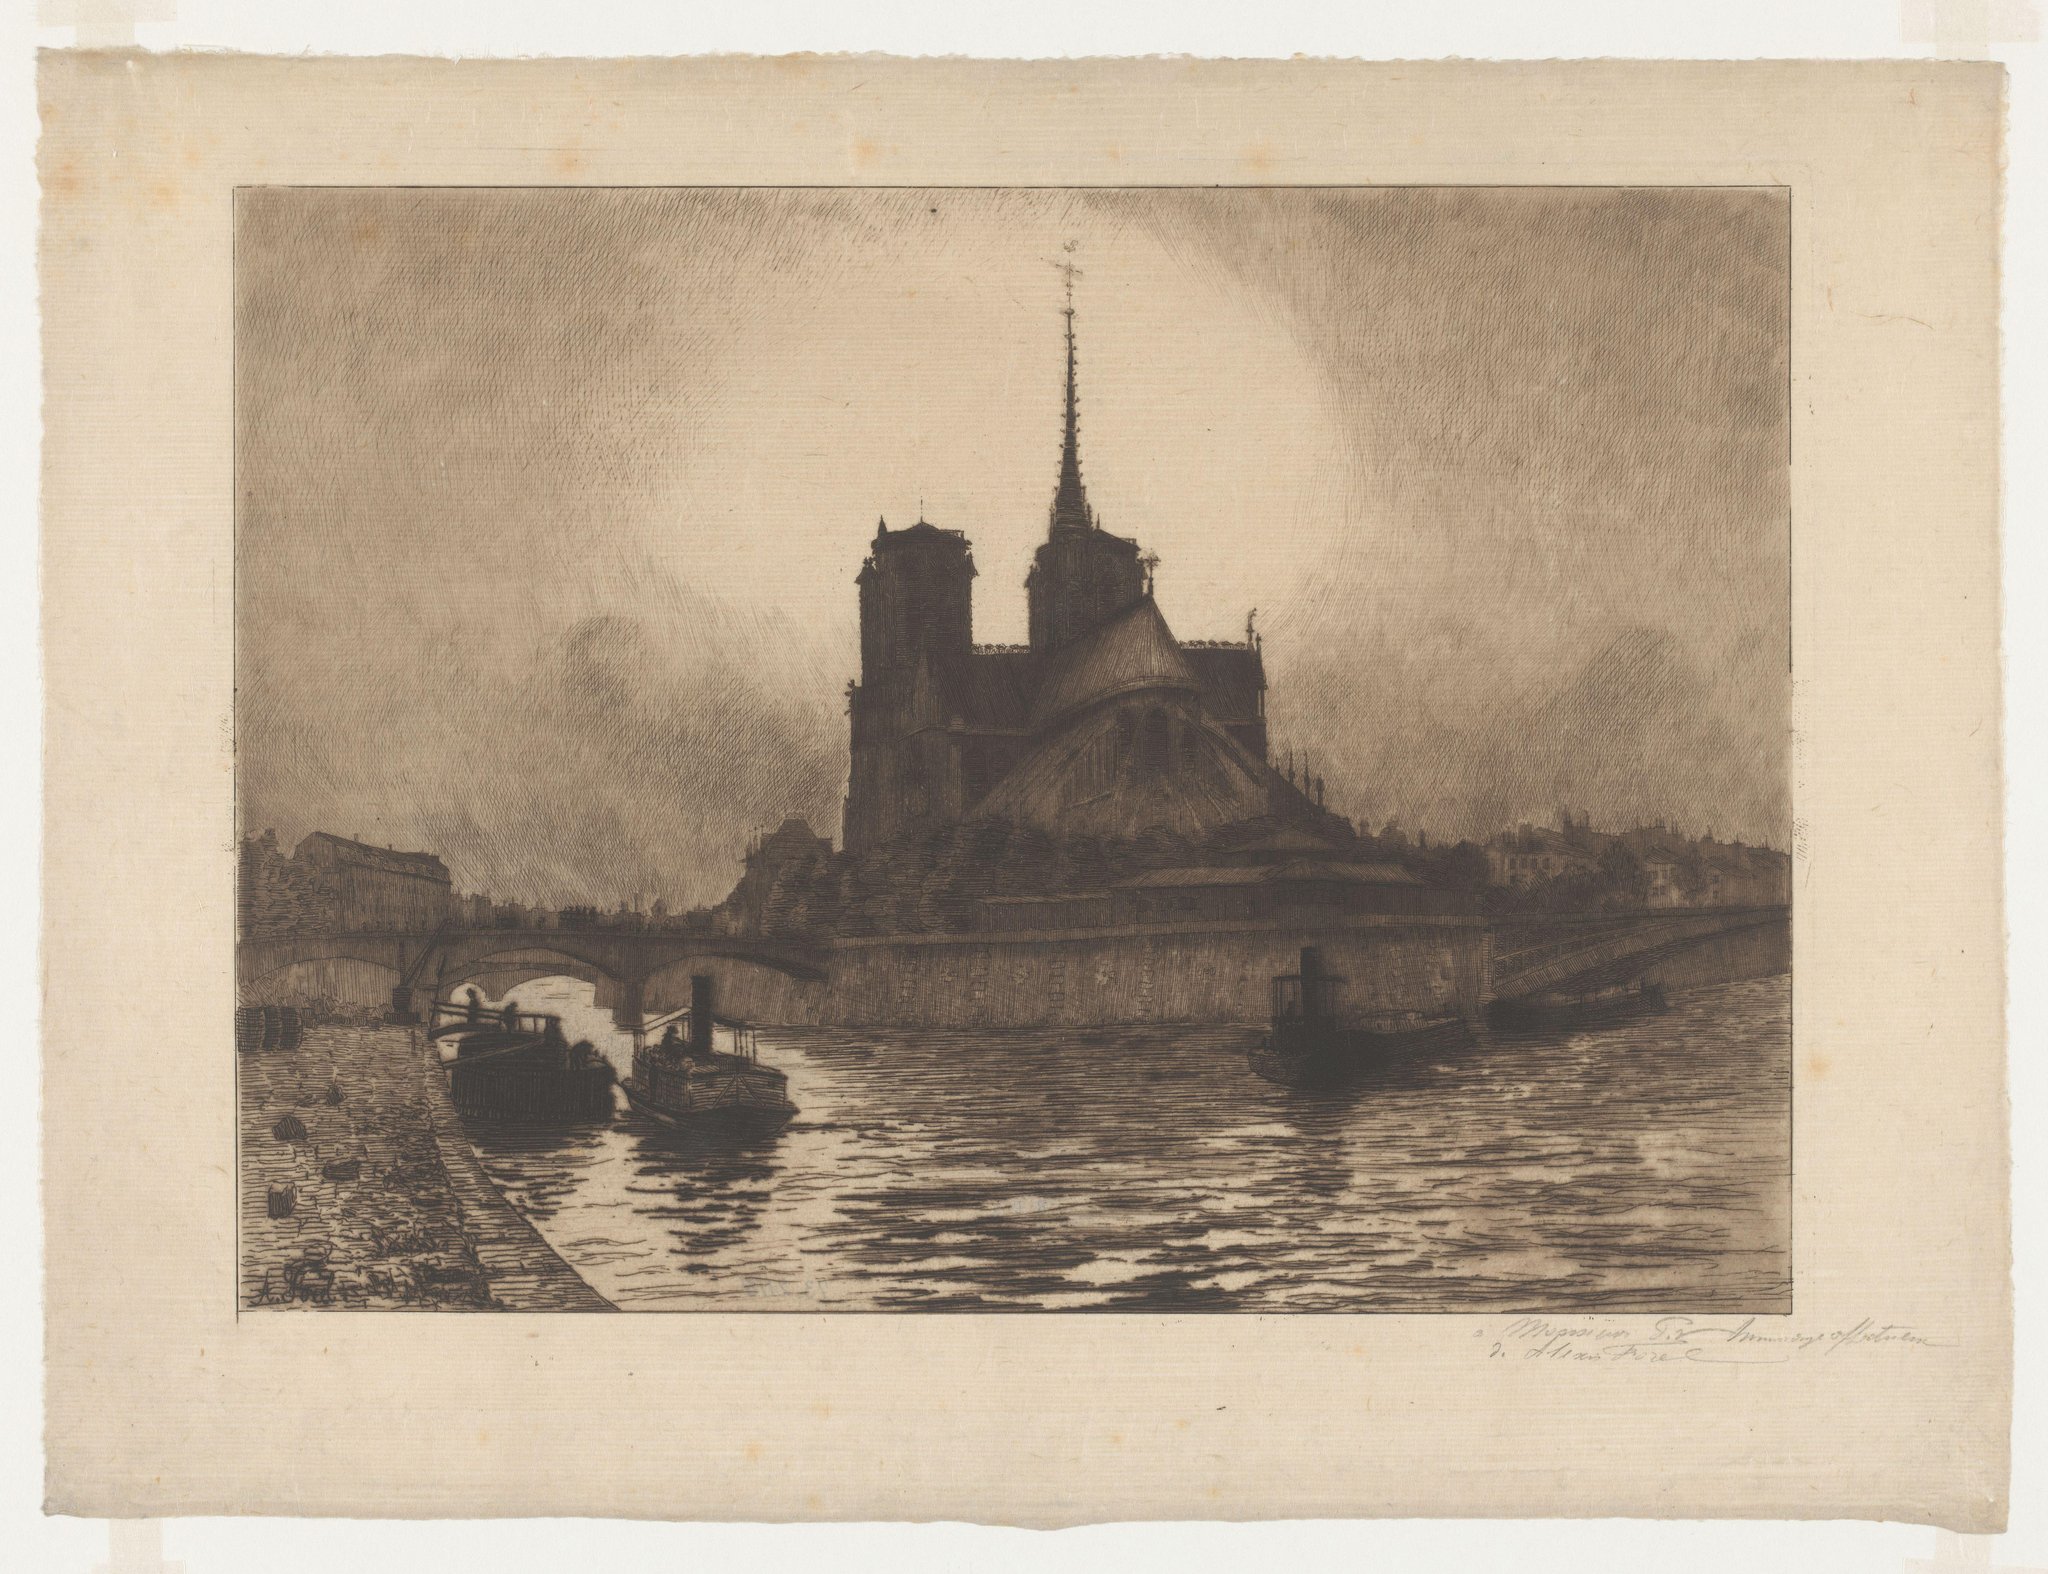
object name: print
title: Gezicht op de achterkant van de Notre-Dame te Parijs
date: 1862-1913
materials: paper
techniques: engraving, etching, intaglio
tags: city-view in general; 'veduta', church (exterior)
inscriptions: collector's mark: Lugt 2233